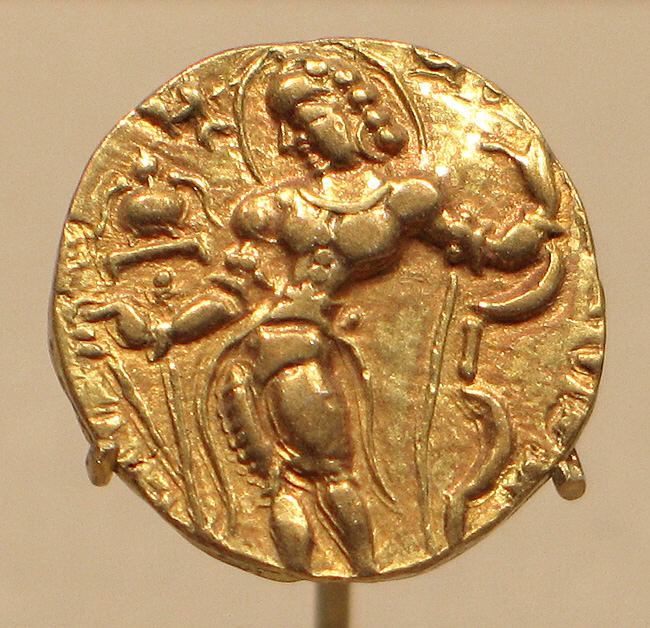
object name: coin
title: Gold Coin Showing King Kumaragupta as an Archer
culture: indian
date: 415-455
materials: gold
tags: gupta,kings